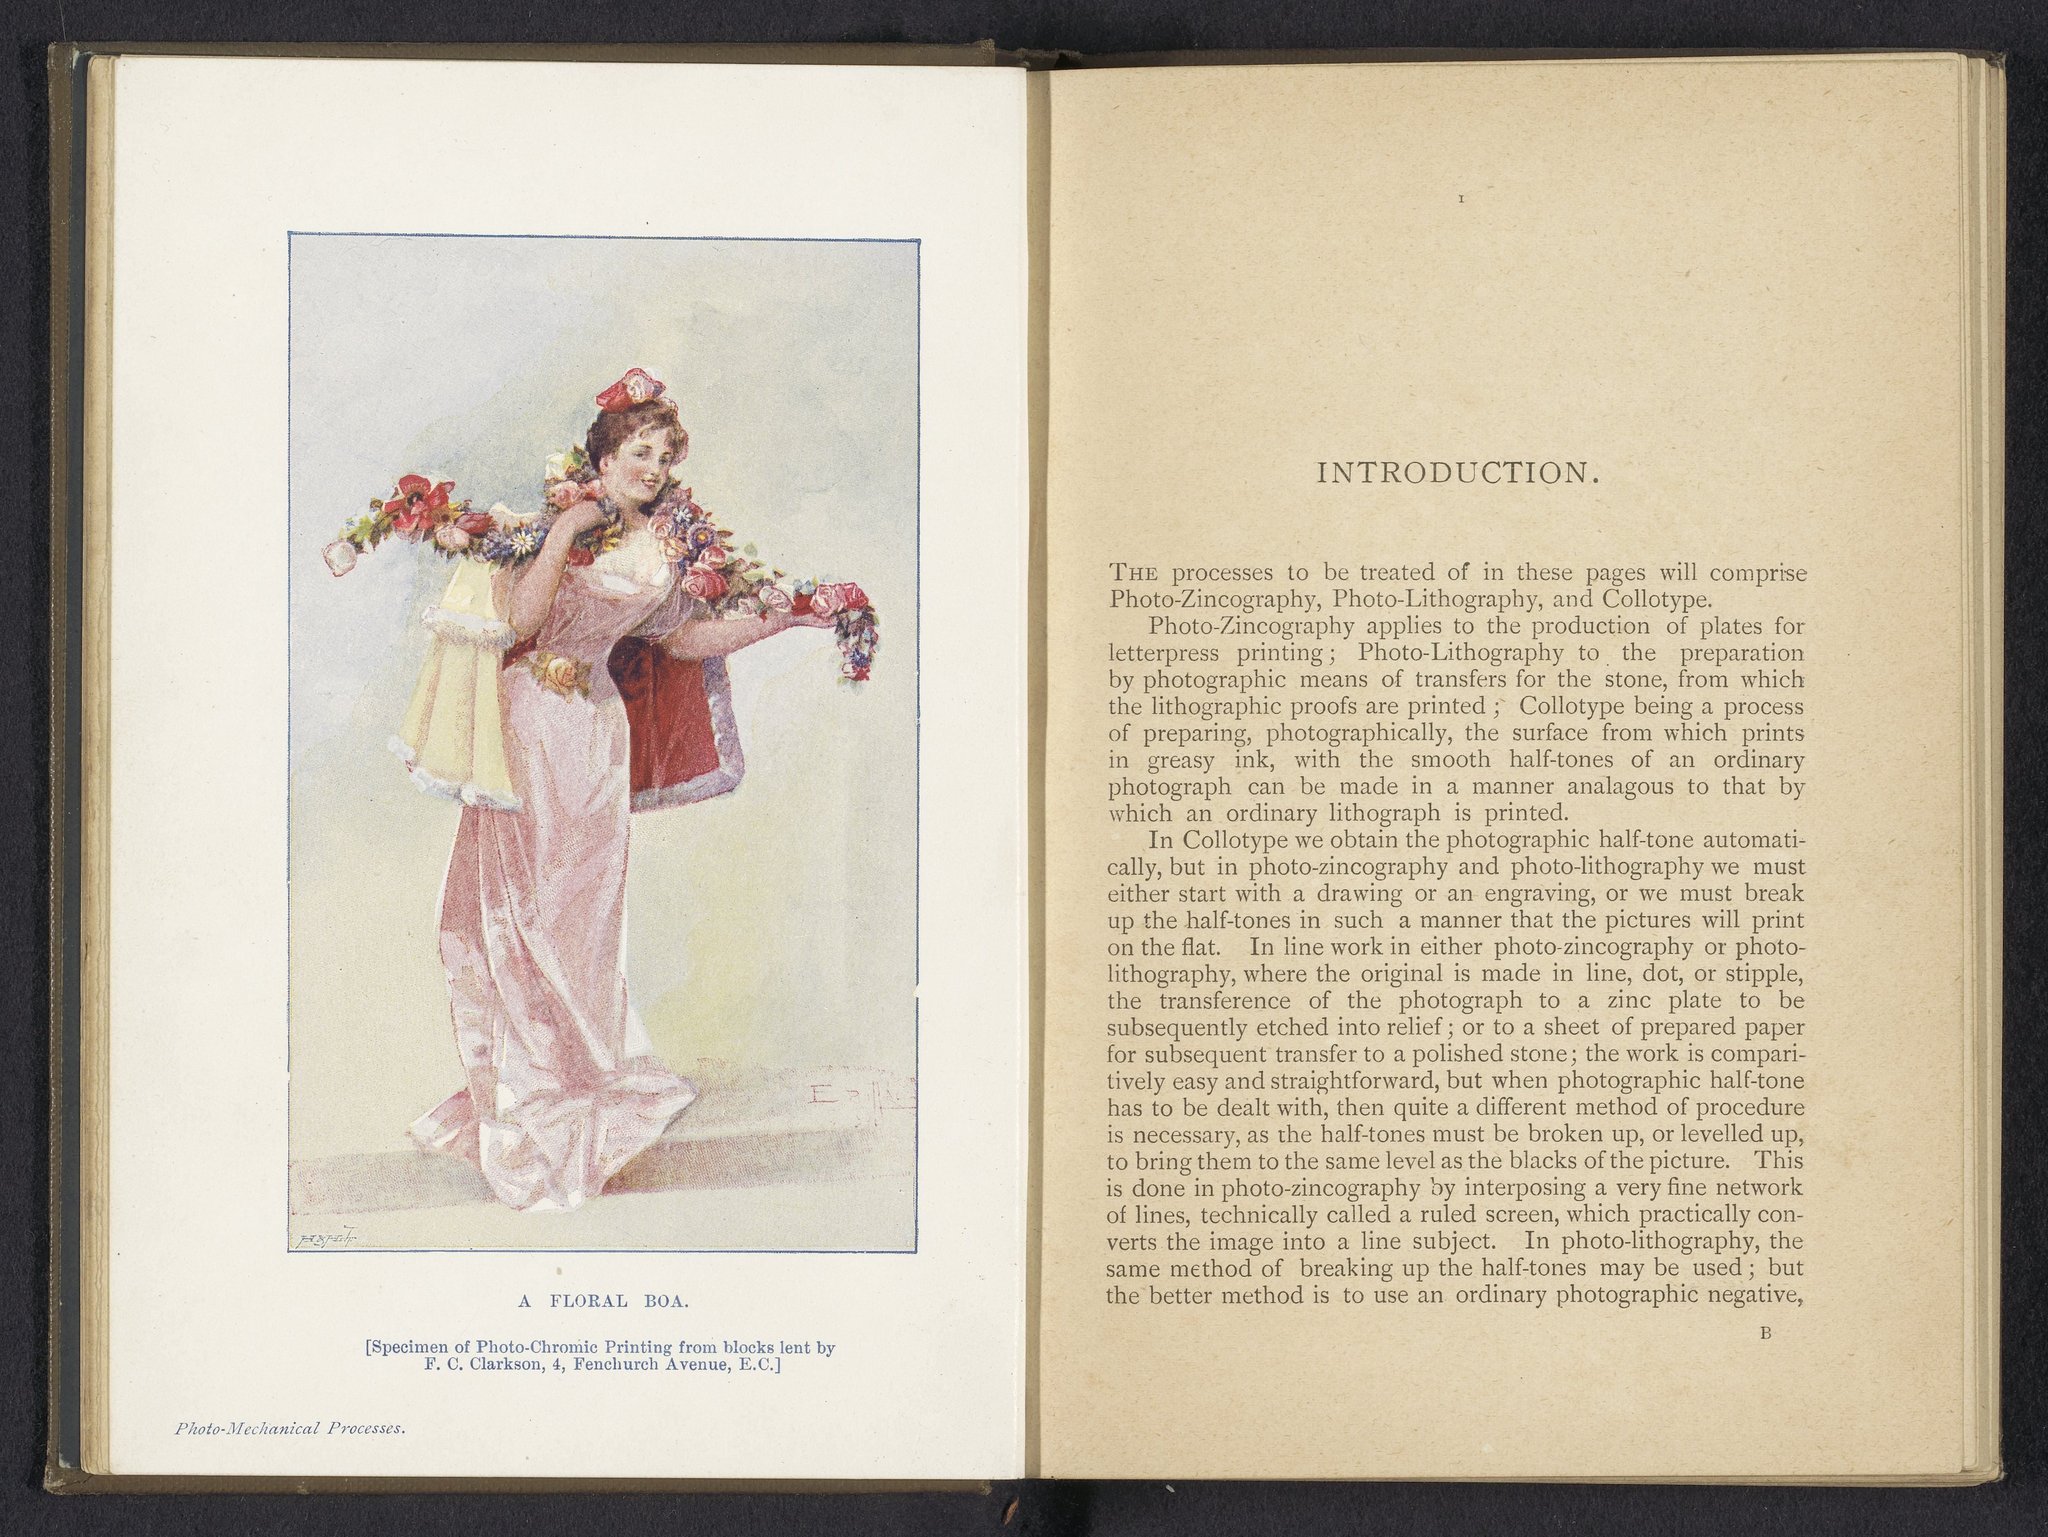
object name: page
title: A floral boa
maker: Anonymous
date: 1887-1897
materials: paper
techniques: color autotype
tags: cut flowers; nosegay, bunch of flowers, adult woman